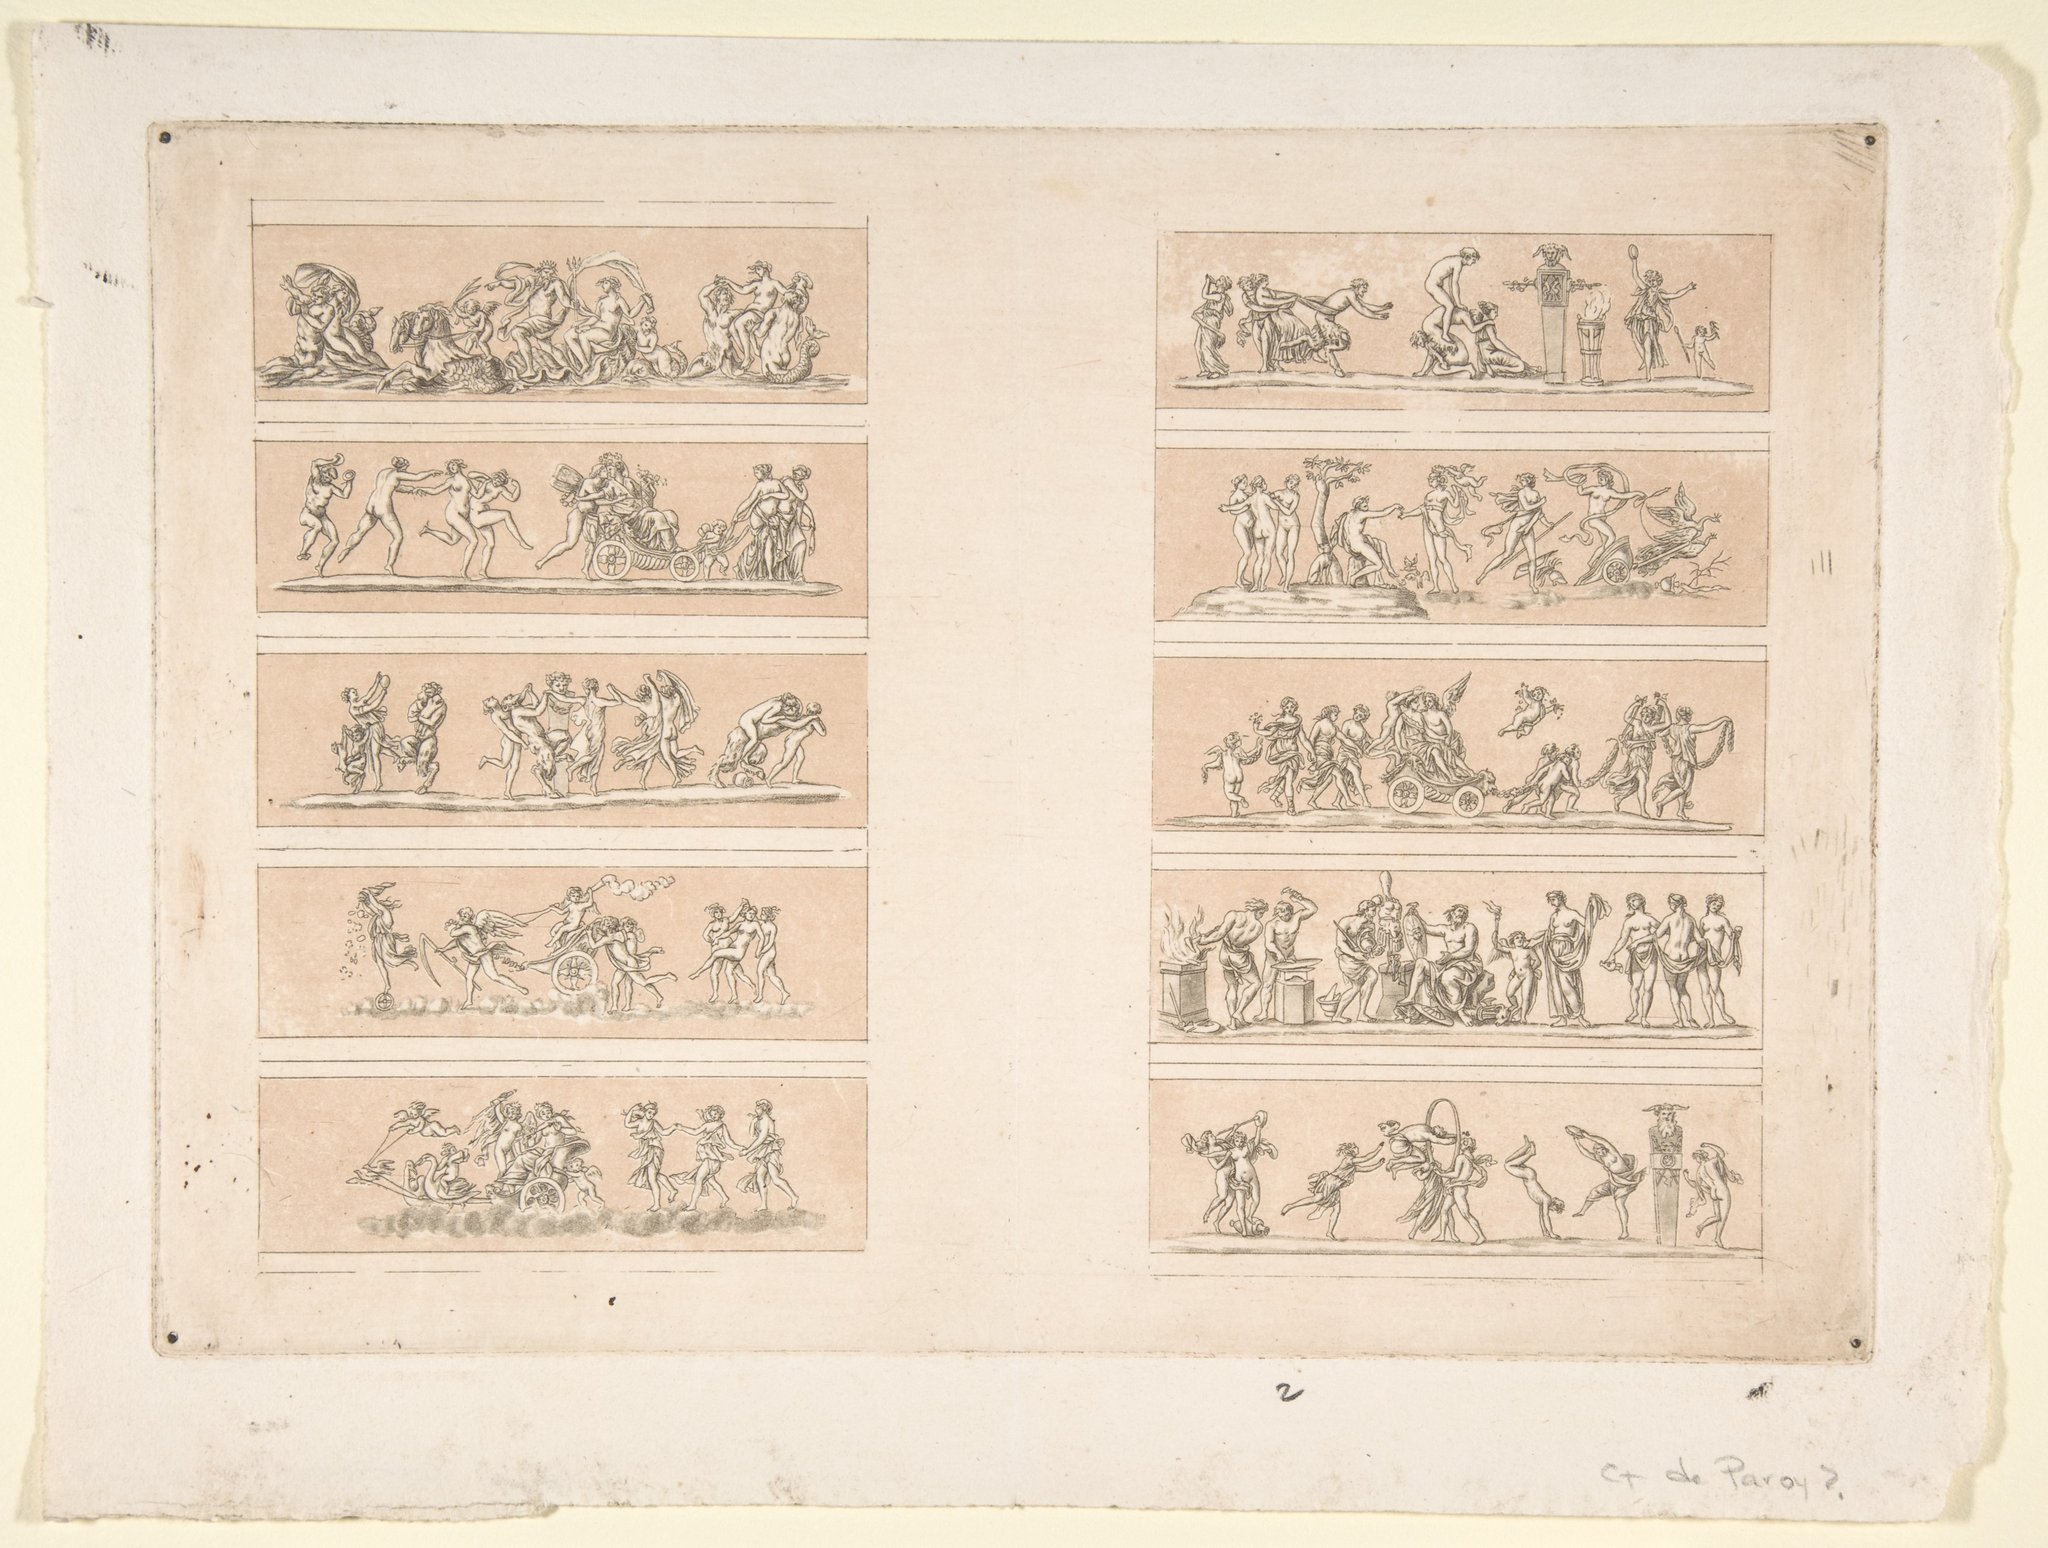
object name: print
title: Plate with Ten Bacchanal Scenes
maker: jean philippe guy le gentil, comte de paroy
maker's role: artist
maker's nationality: french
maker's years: 1750-1824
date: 1770-1824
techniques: etching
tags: men,male nudes,female nudes,satyrs,chariots